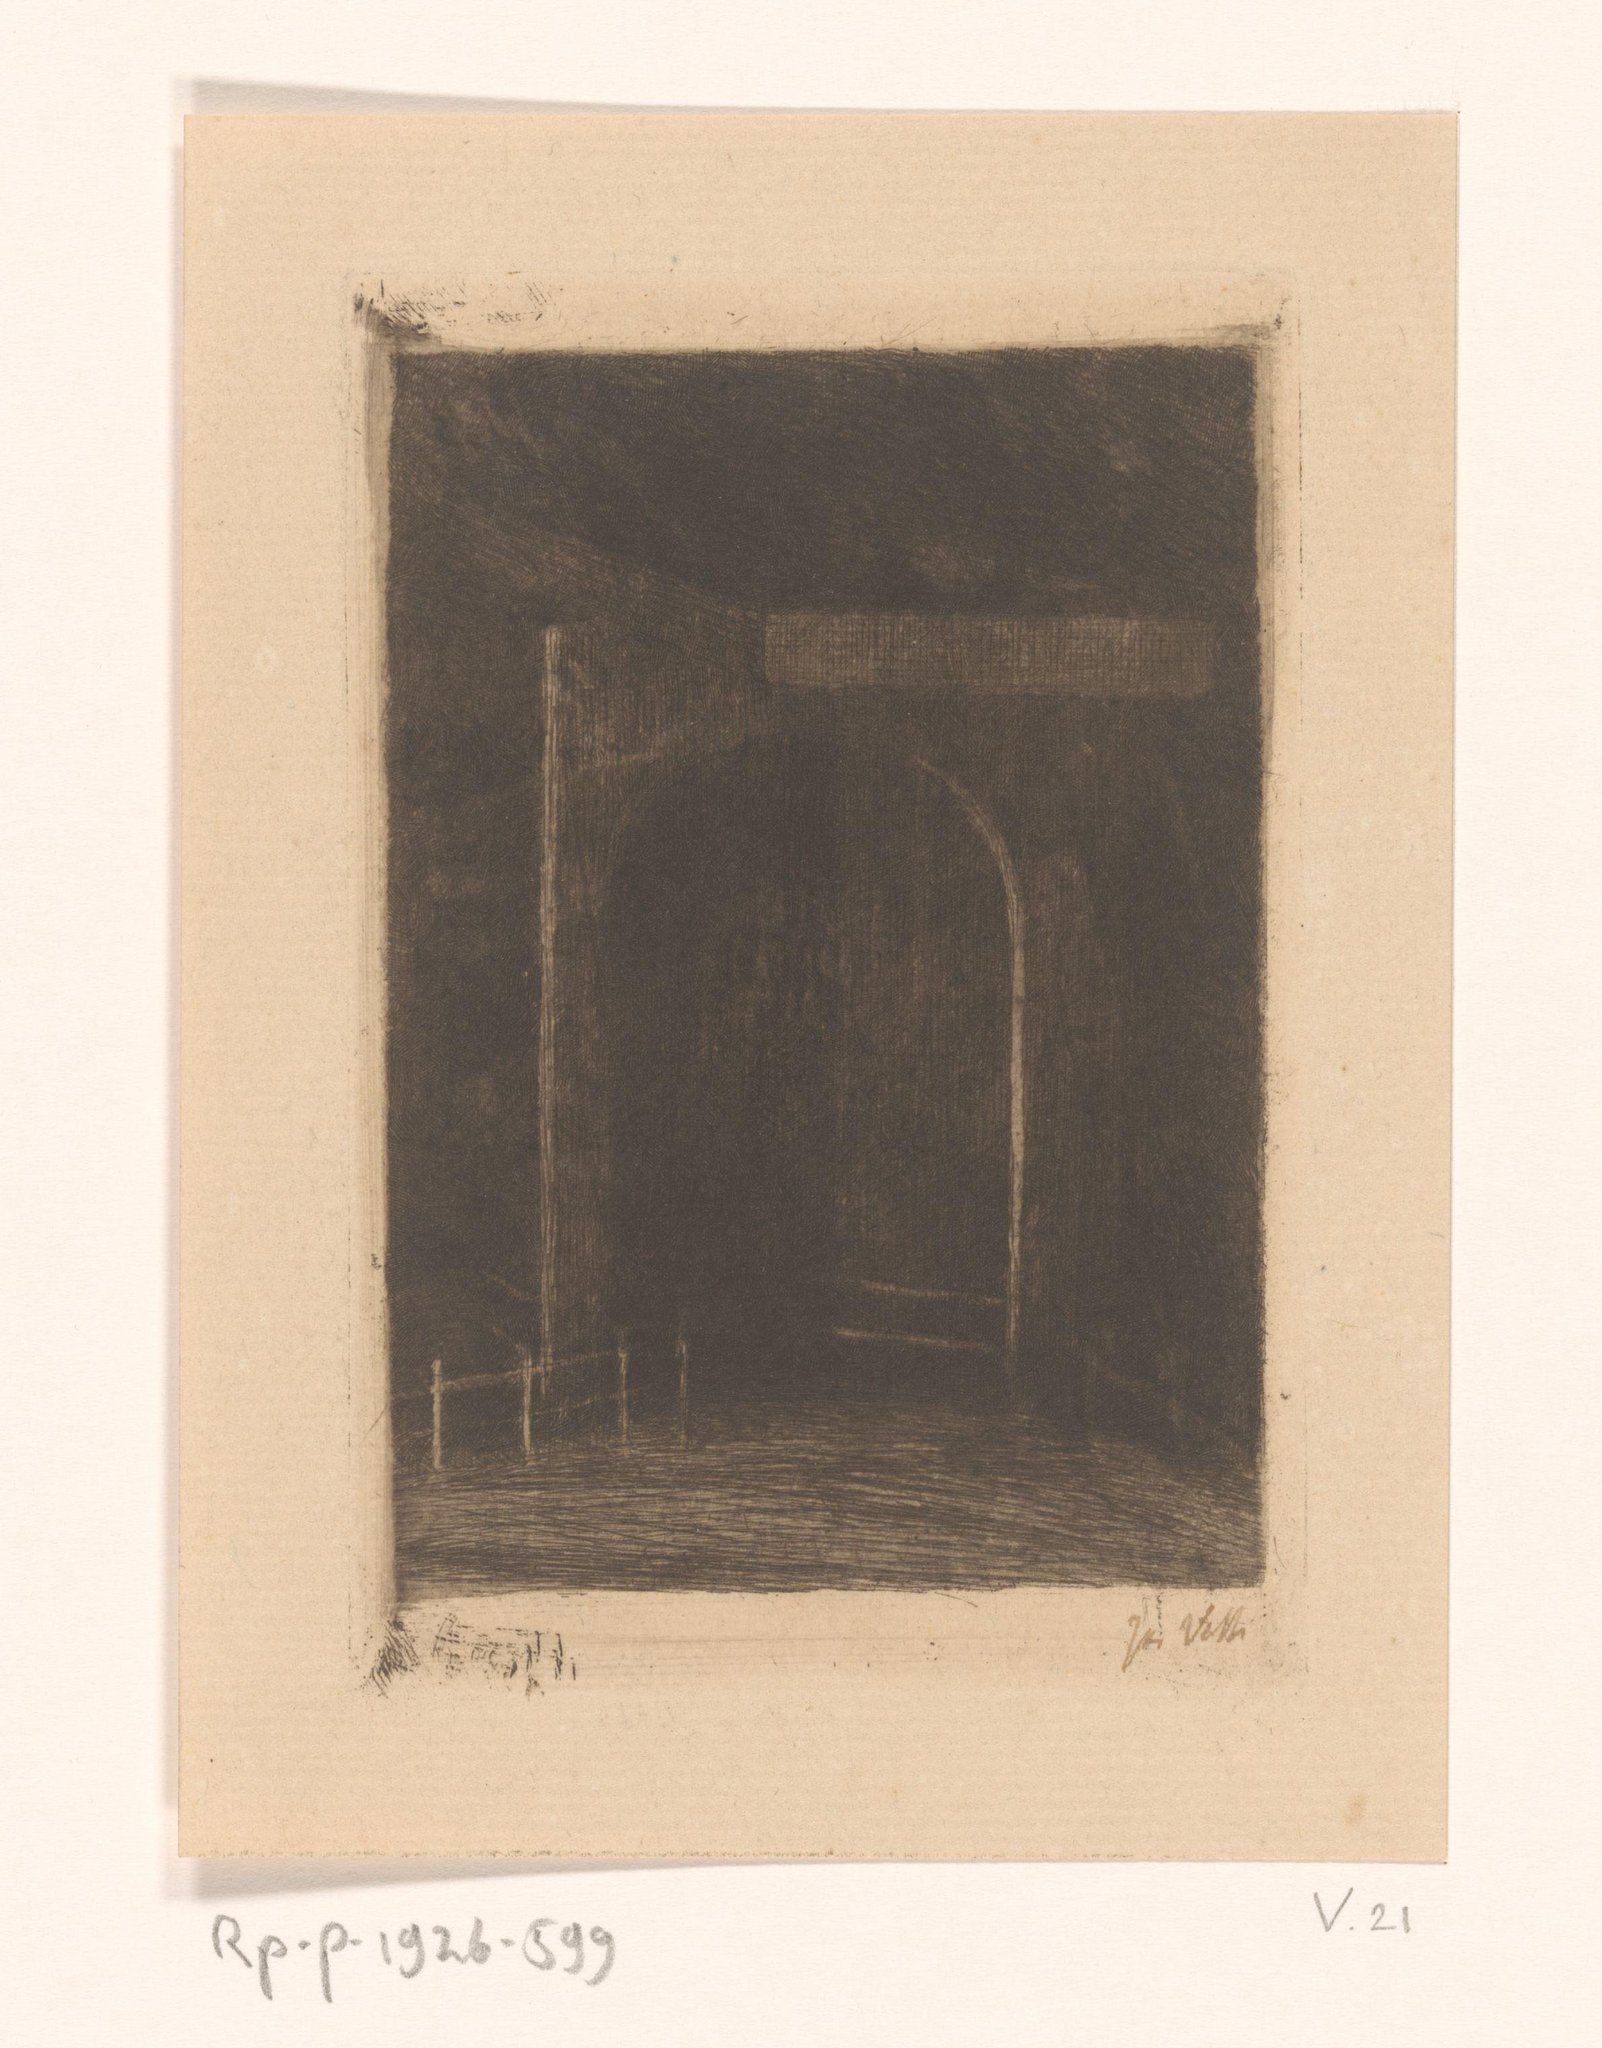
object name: print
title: Ophaalbrug aan de Overtoom, Amsterdam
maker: jan veth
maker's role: designer, draughtsman, painter, print maker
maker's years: 1864-1925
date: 1886-1925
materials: paper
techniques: etching, intaglio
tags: bridge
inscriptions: collector's mark: Lugt 2228